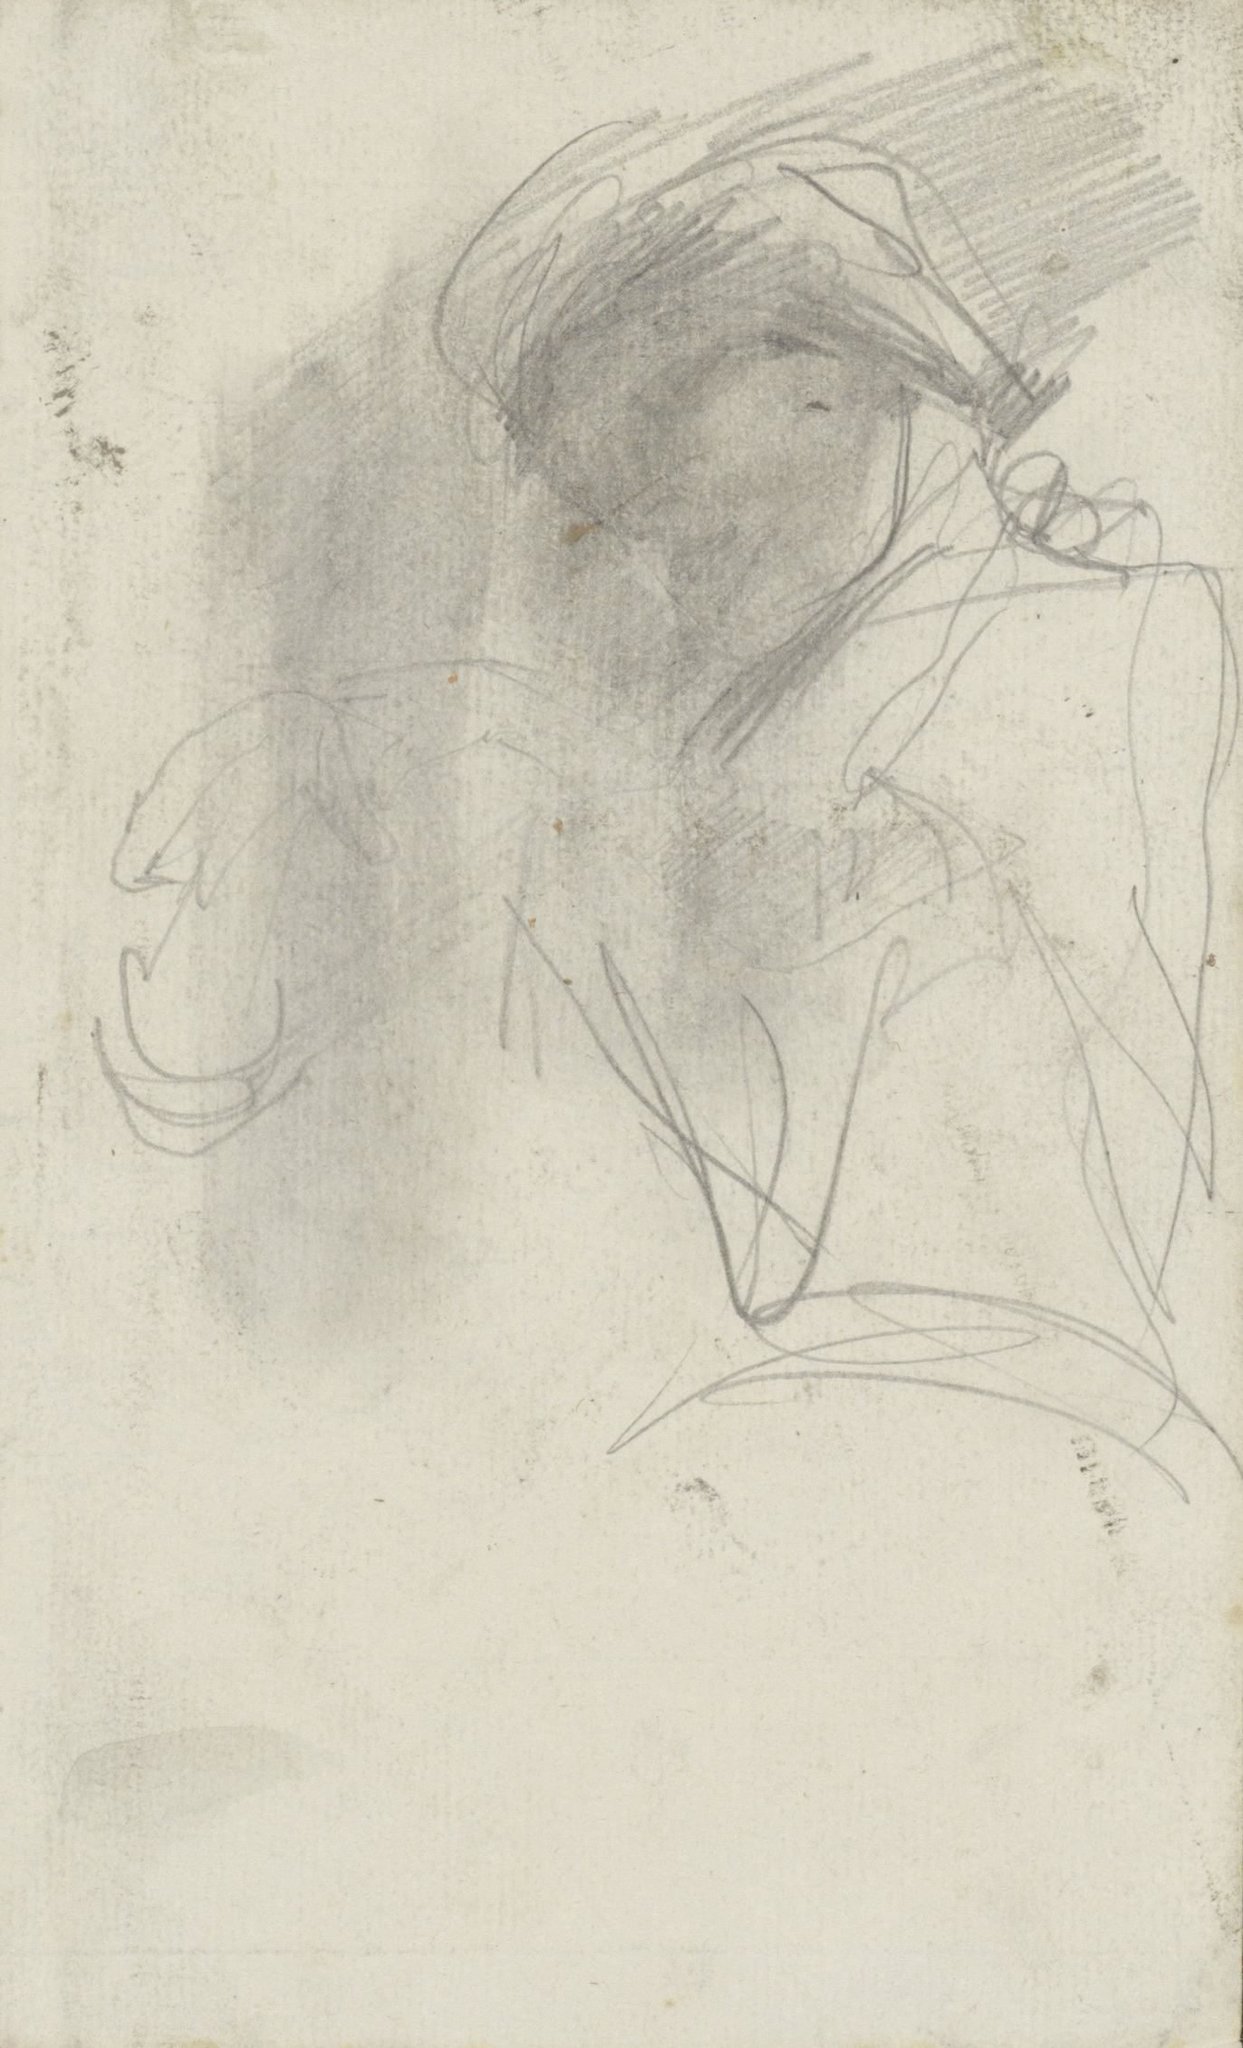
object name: drawing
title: Vrouw met opgeheven armen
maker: george hendrik breitner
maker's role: draughtsman, painter, print maker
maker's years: 1857-1923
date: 1882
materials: paper, pencil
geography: rotterdam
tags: adult woman